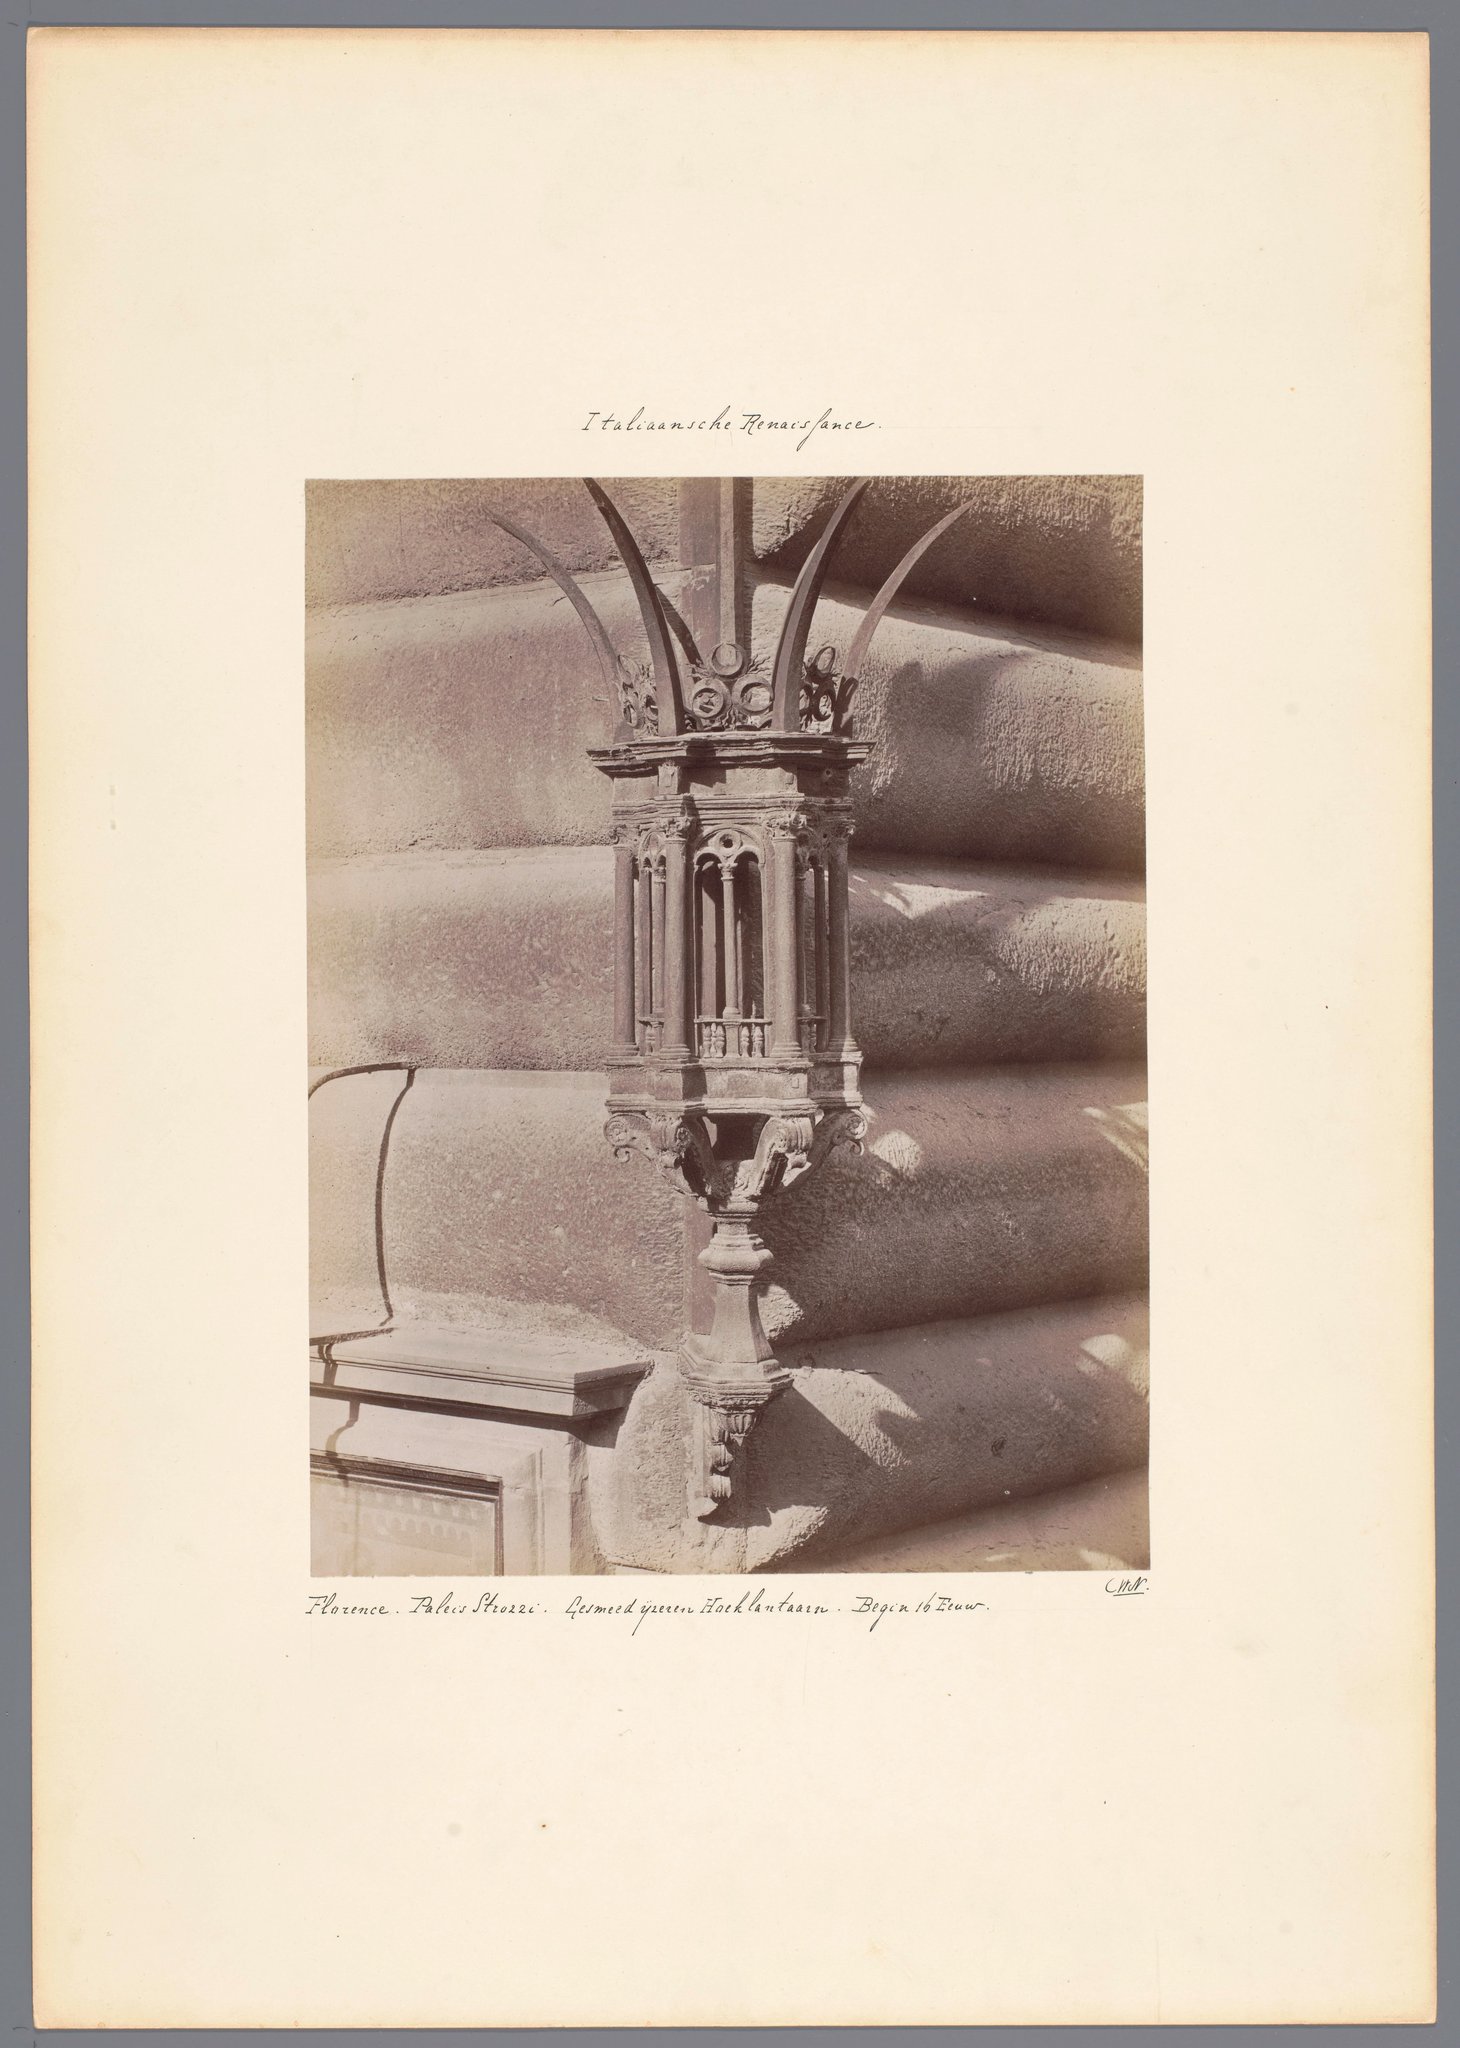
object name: photograph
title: Florence. Paleis Strozzi . Gesmeed ijzeren Hoeklantaarn . Begin 16 Eeuw.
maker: Anonymous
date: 1875-1900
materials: cardboard, photographic support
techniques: albumen print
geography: florence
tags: lantern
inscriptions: collector's mark: ‘INSTITUUT VOOR KUNST-NIJVERHEIDSONDERWIJS GABRIËL METSUSTRAAT No. 16 AMSTERDAM’, collector's mark: ‘KUNSTNIJVERHEIDSCHOOL QUELLINUS AMSTERDAM FRANS HALSSTRAAT 14.’, inscription: ‘CWN.’, inscription: ‘Italiaansche Renaissance.’